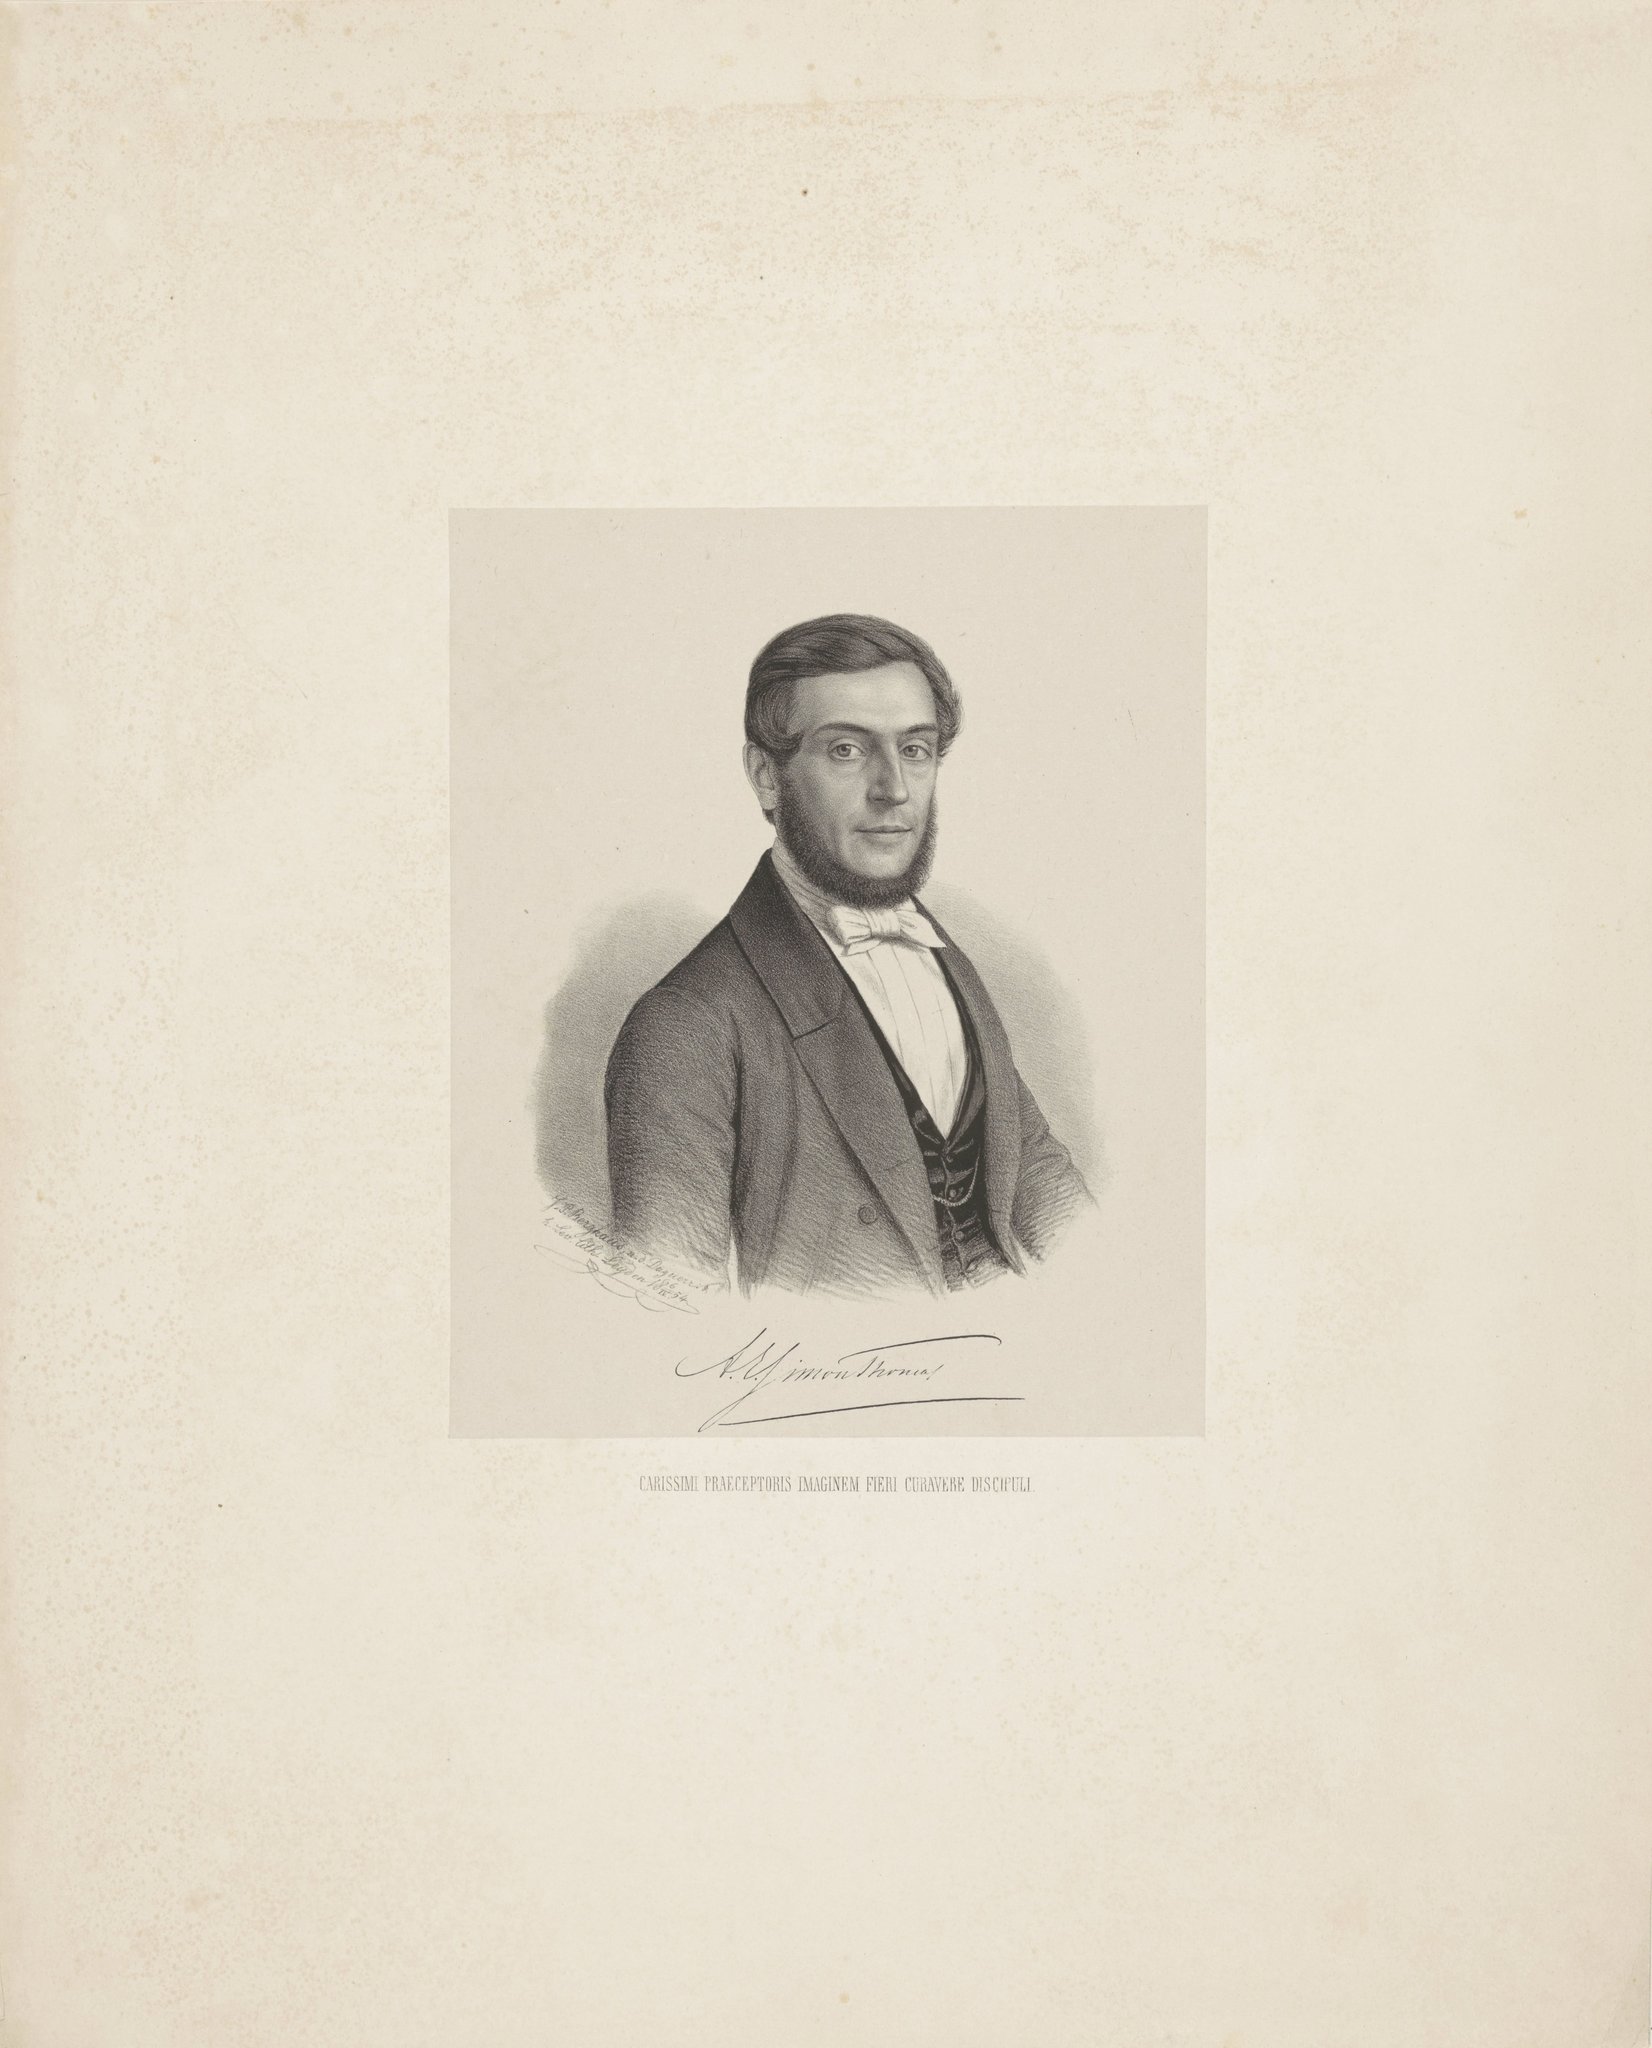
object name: print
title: Portret van Abraham Everardus Simon Thomas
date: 1854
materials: paper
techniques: lithograph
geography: leiden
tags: historical persons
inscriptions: collector's mark: Lugt 2228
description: Onder het portret de signatuur van de geportretteerde en een onderschrift in Latijn.